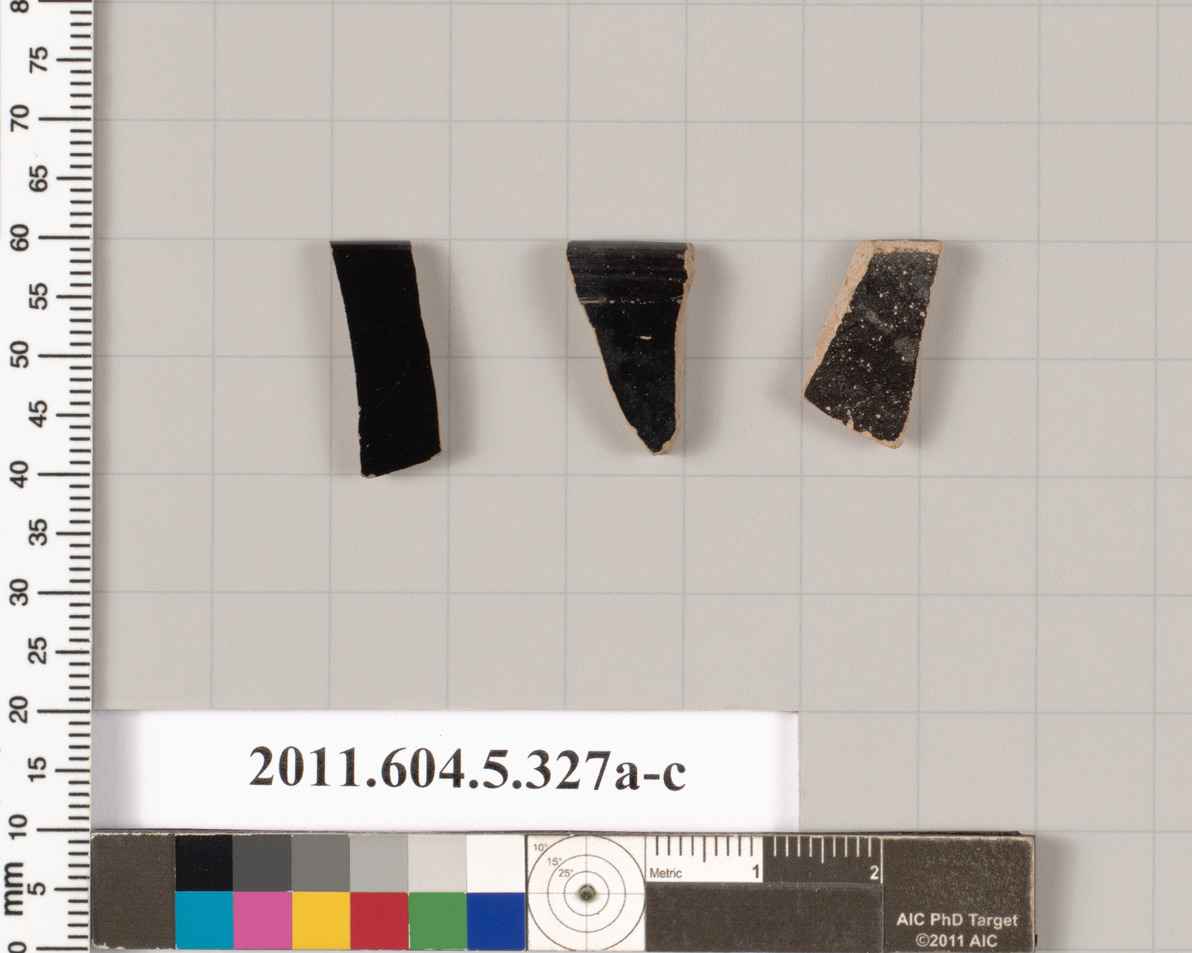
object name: kylix fragment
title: Terracotta rim fragments of kylikes (drinking cups)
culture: greek, attic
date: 600-401 BCE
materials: terracotta